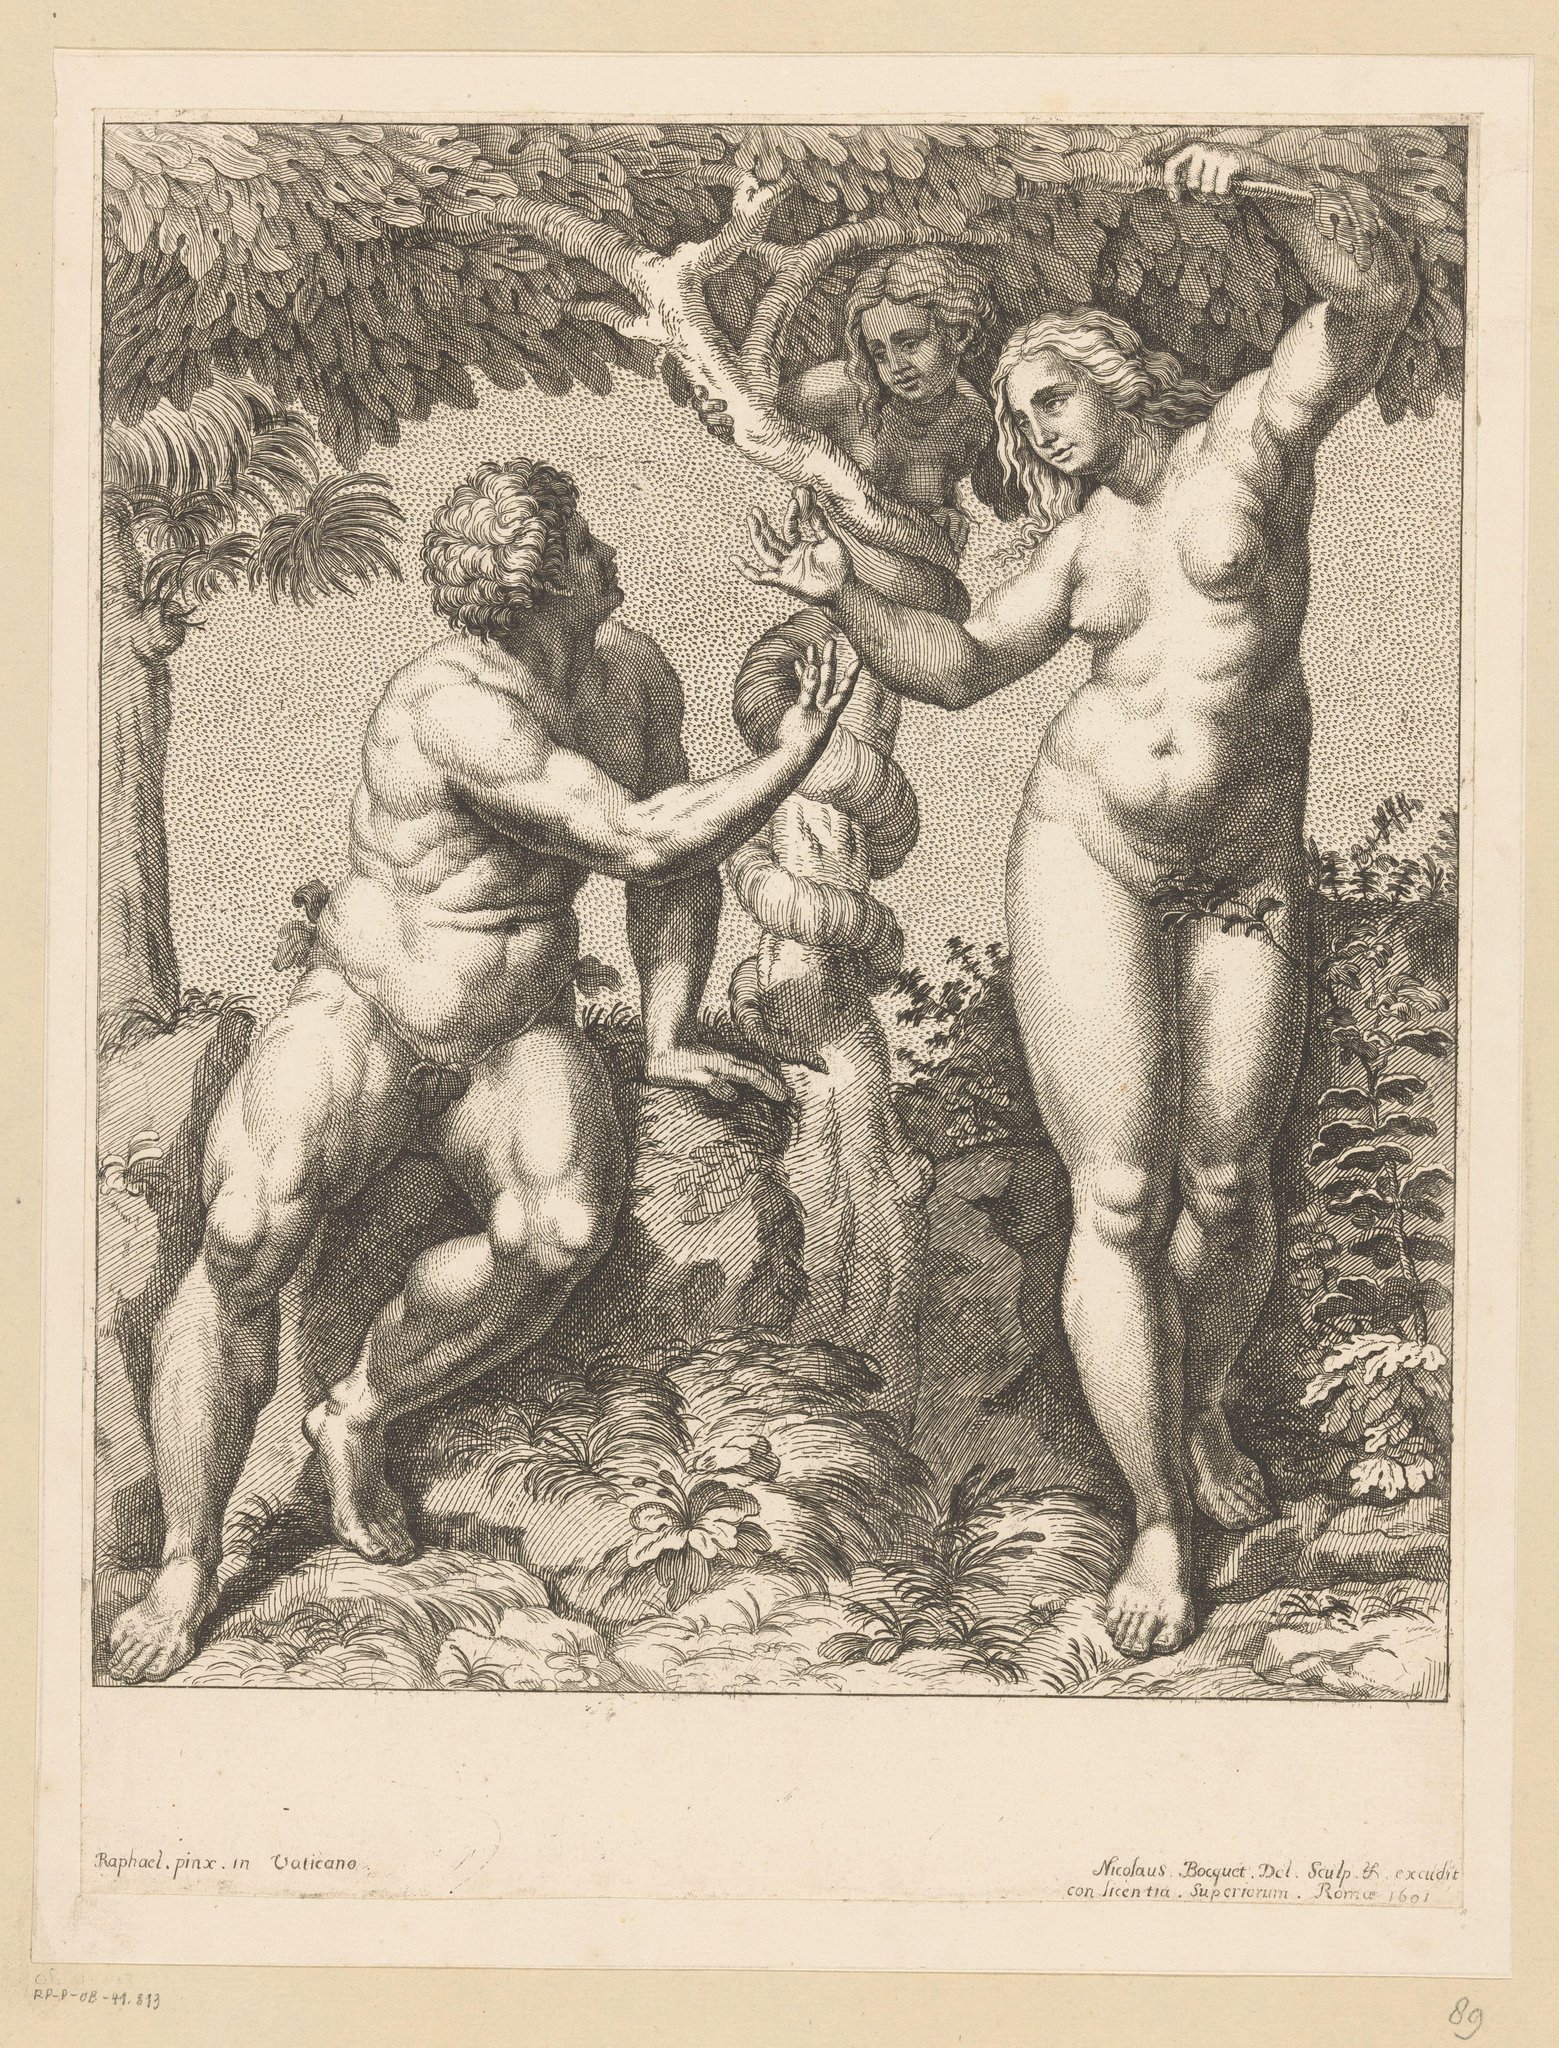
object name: print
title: Adam en Eva verleid door de slang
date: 1691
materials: paper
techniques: engraving, etching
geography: vatican museums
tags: eve offers the fruit to adam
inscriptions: collector's mark: Lugt 240